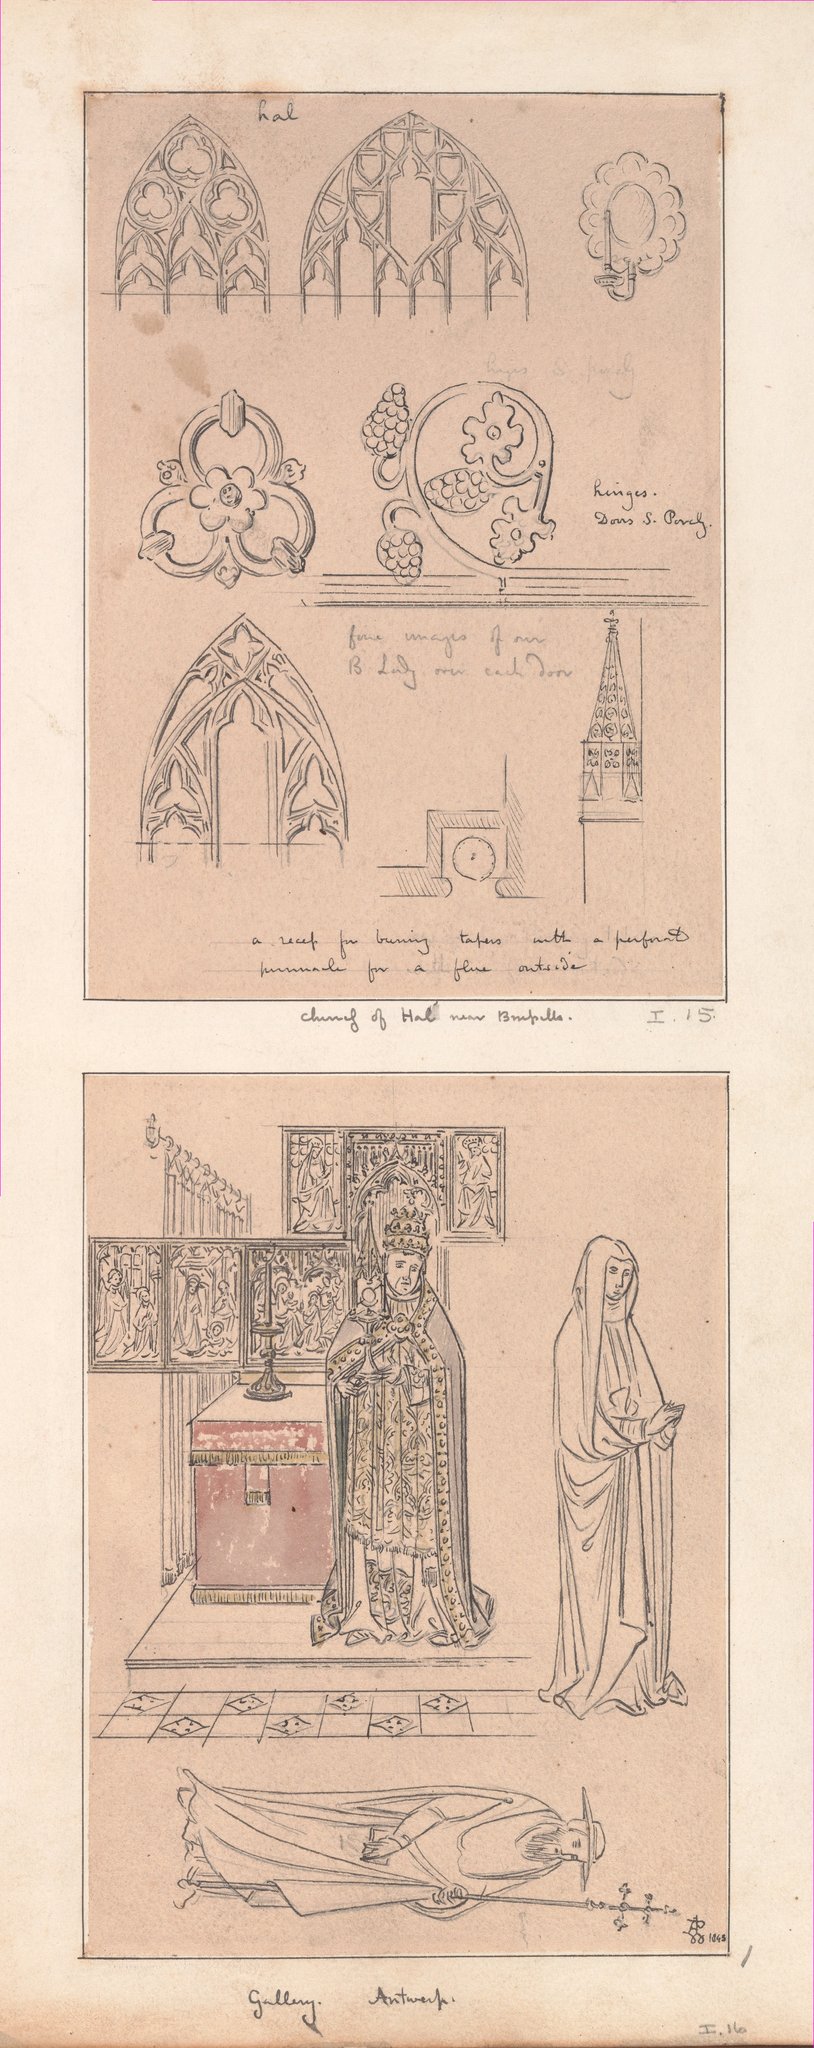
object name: album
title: Sketches, Volume one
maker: augustus welby northmore pugin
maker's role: designer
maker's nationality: british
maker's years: 1812-1852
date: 1833-1845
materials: graphite, ink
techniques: wash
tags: men,women,flowers